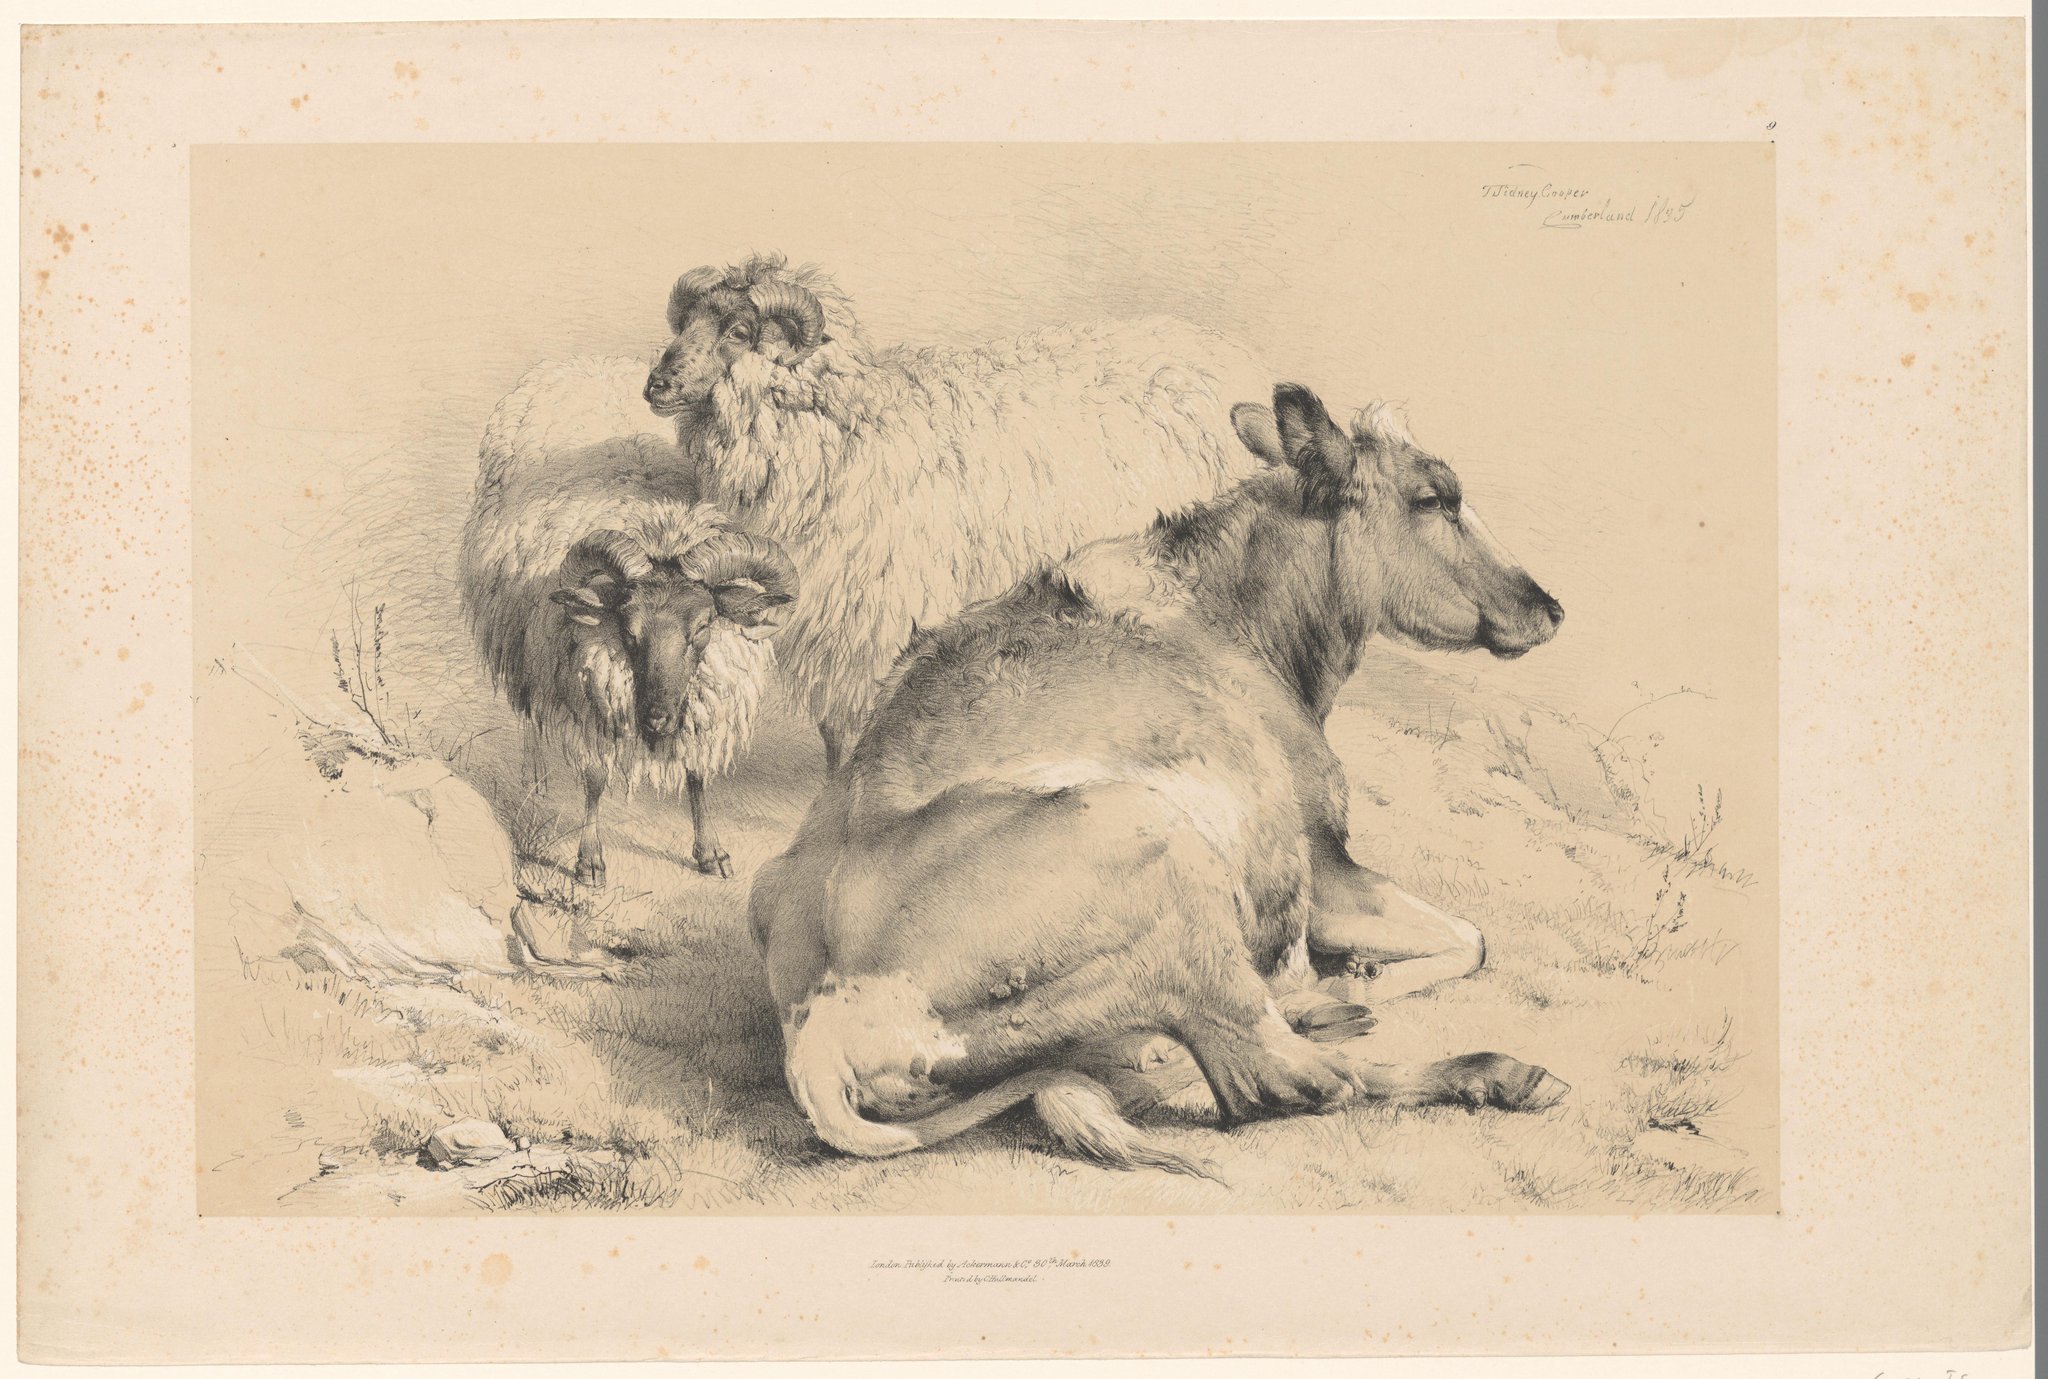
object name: print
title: Groups of cattle, drawn from nature by T.S. Cooper 1839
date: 1839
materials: paper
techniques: tone lithography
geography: london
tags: cow, ram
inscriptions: collector's mark: Lugt 2228